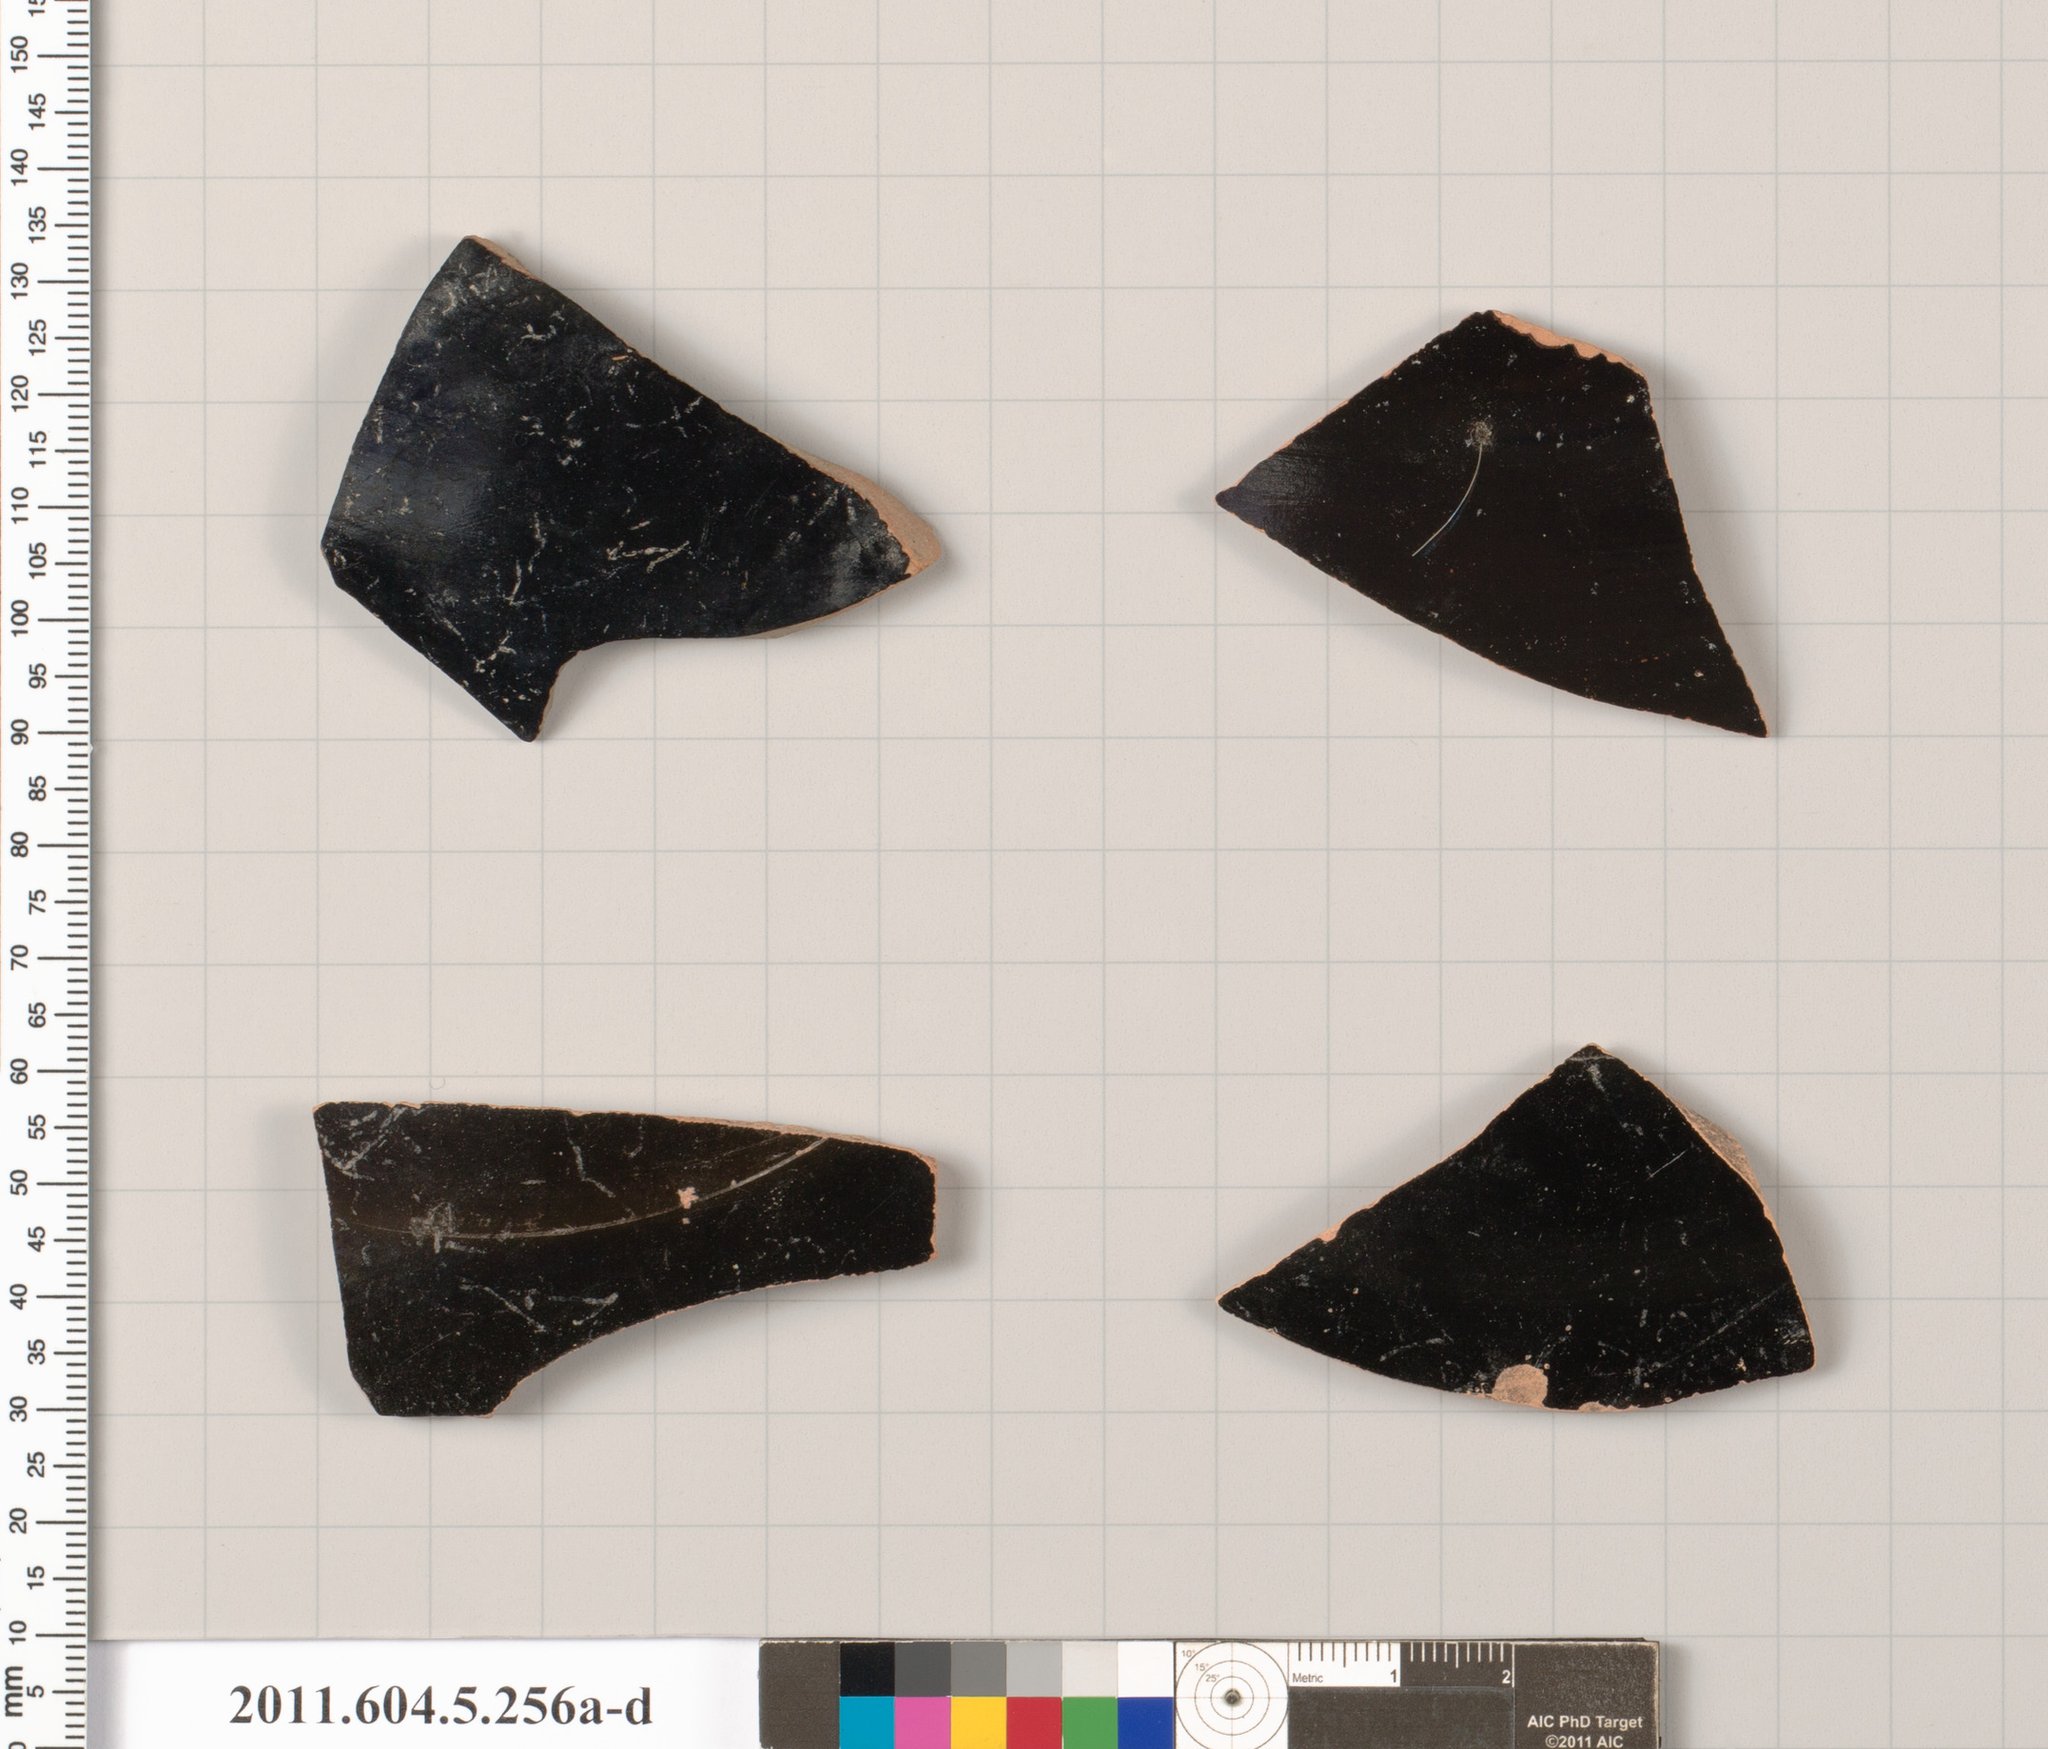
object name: kylix fragment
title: Terracotta fragments of kylikes (drinking cups)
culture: greek, attic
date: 600-401 BCE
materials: terracotta